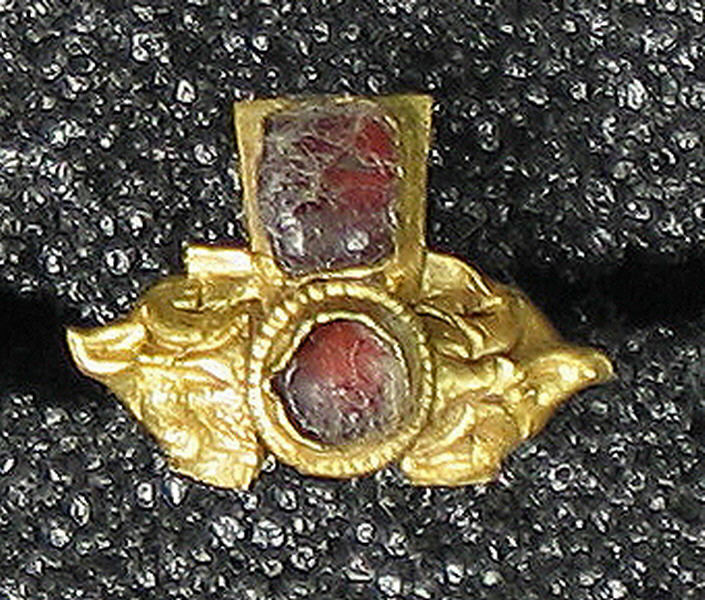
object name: pair of earring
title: Pair of Ruby Earrings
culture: indonesian, central java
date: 701-1200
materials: gold, gemstone